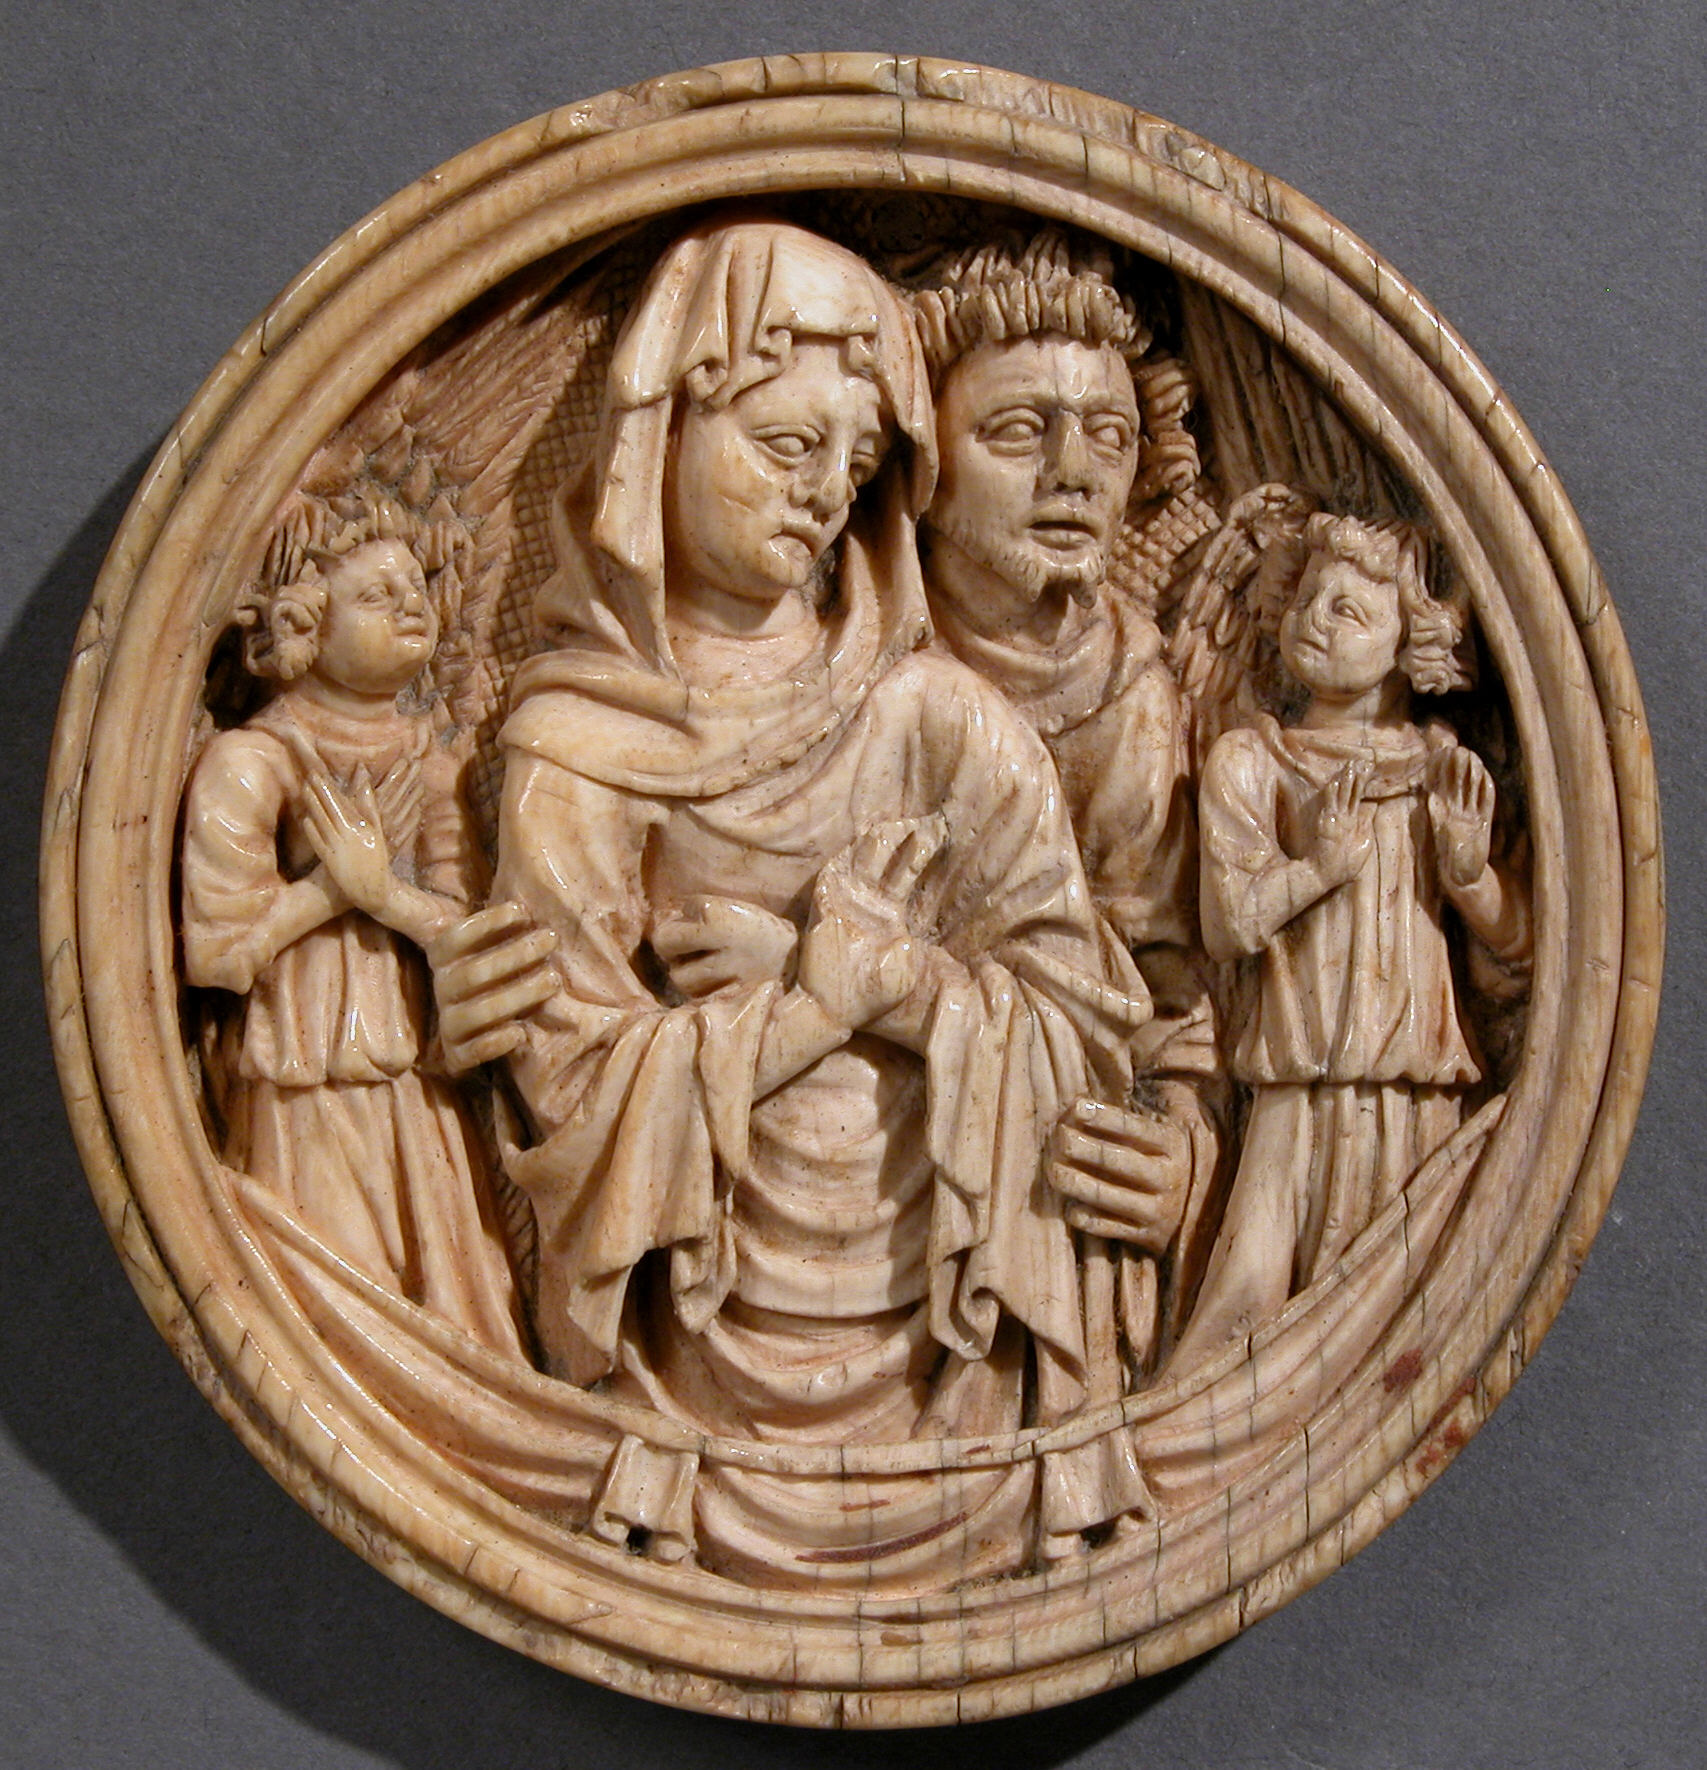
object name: roundel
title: Roundel with the Virgin Mary, Saint John, and Angels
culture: european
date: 1801-1900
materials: ivory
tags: angels,saint john the evangelist,virgin mary